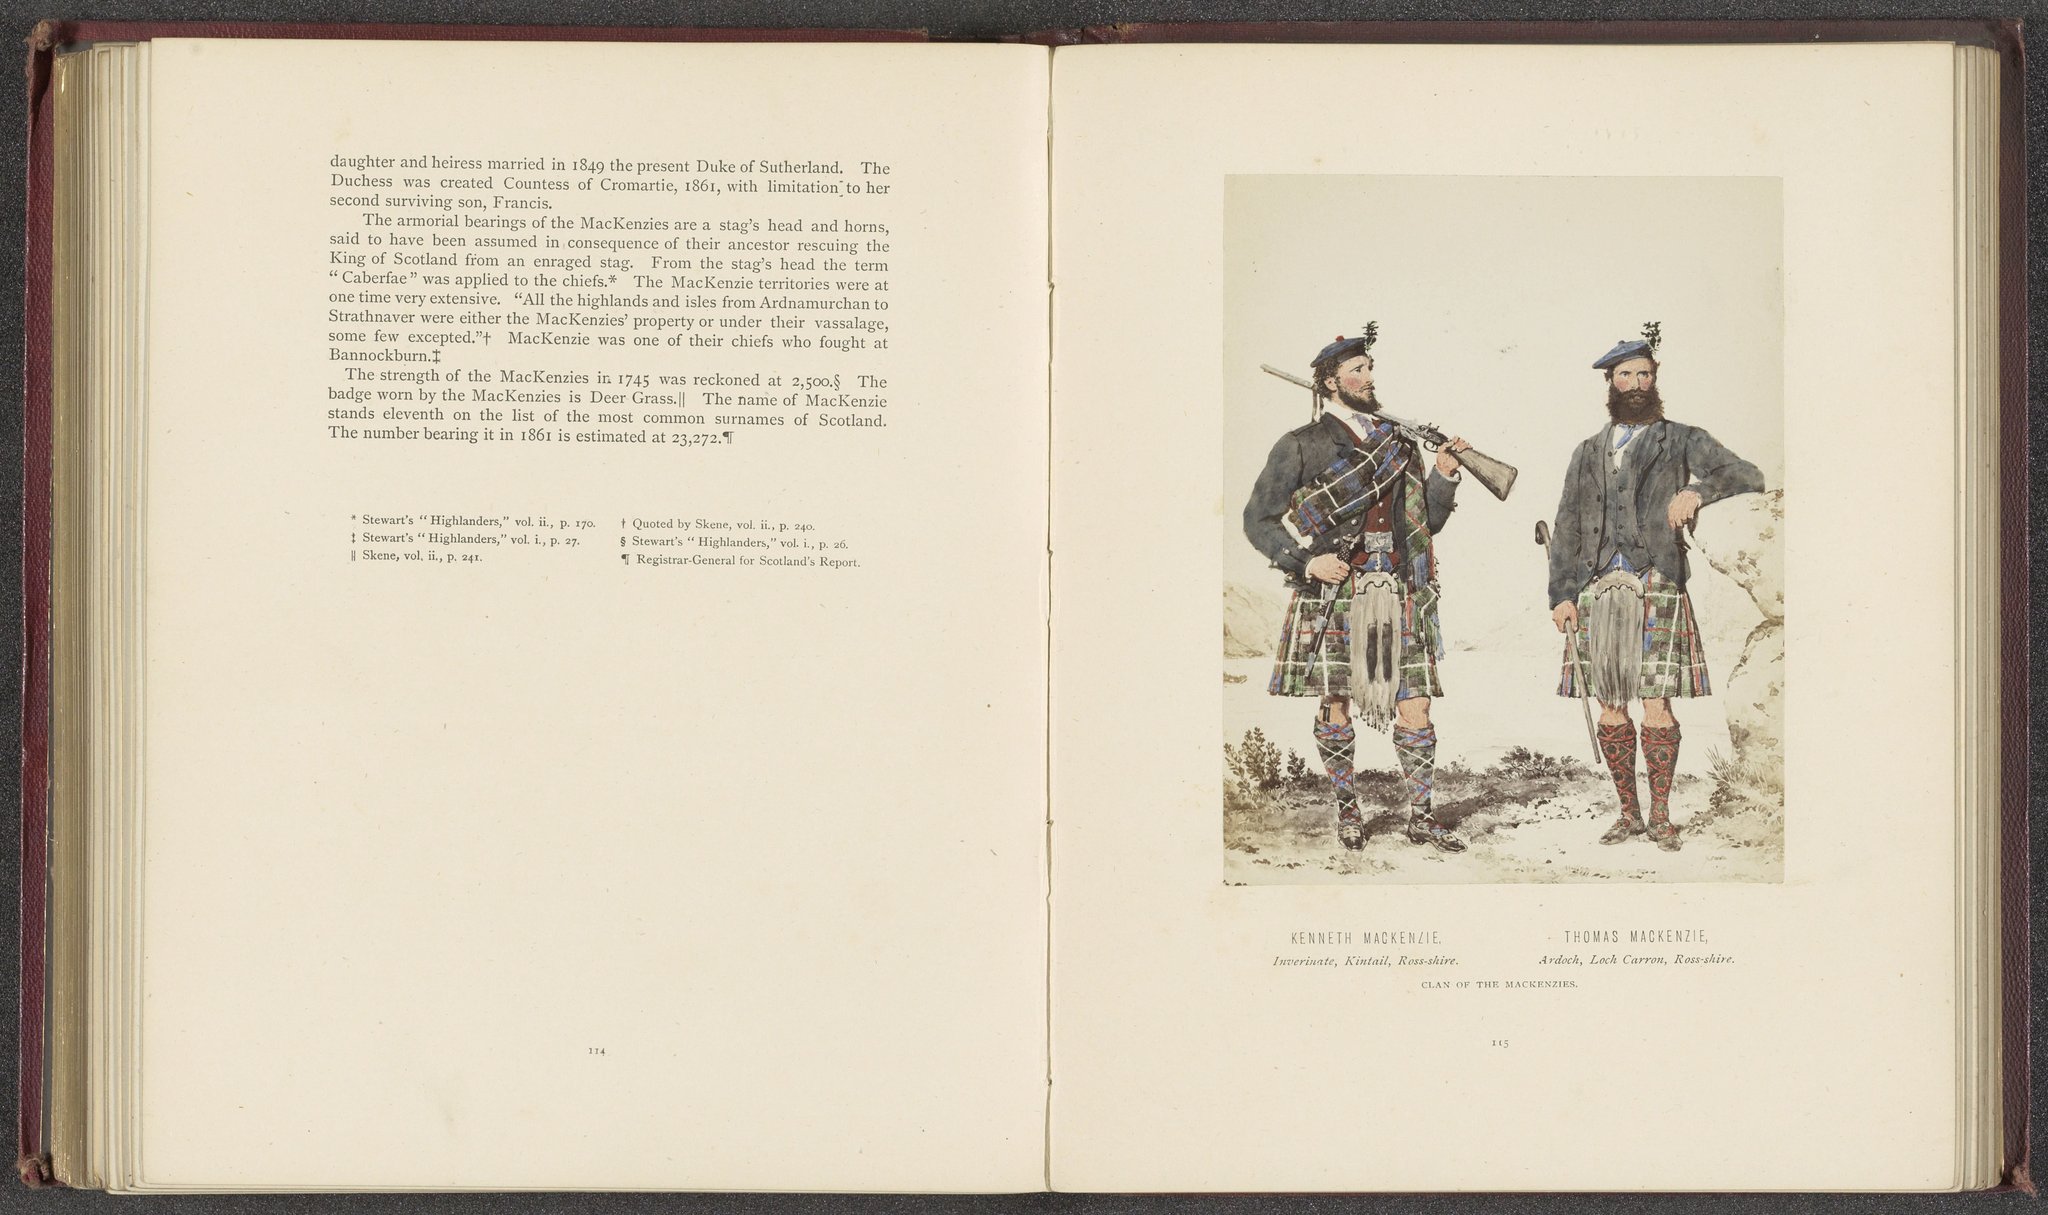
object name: reproduction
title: Kenneth Mackenzie, Inverinate, Kintail, Ross-shire. Thomas Mackenzie, Ardoch, Loch Carron, Ross-shire. Clan of the Mackenzies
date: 1860-1870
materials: photographic support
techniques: albumen print, hand coloring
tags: adult man, firearms: rifle, folk costume, regional costume